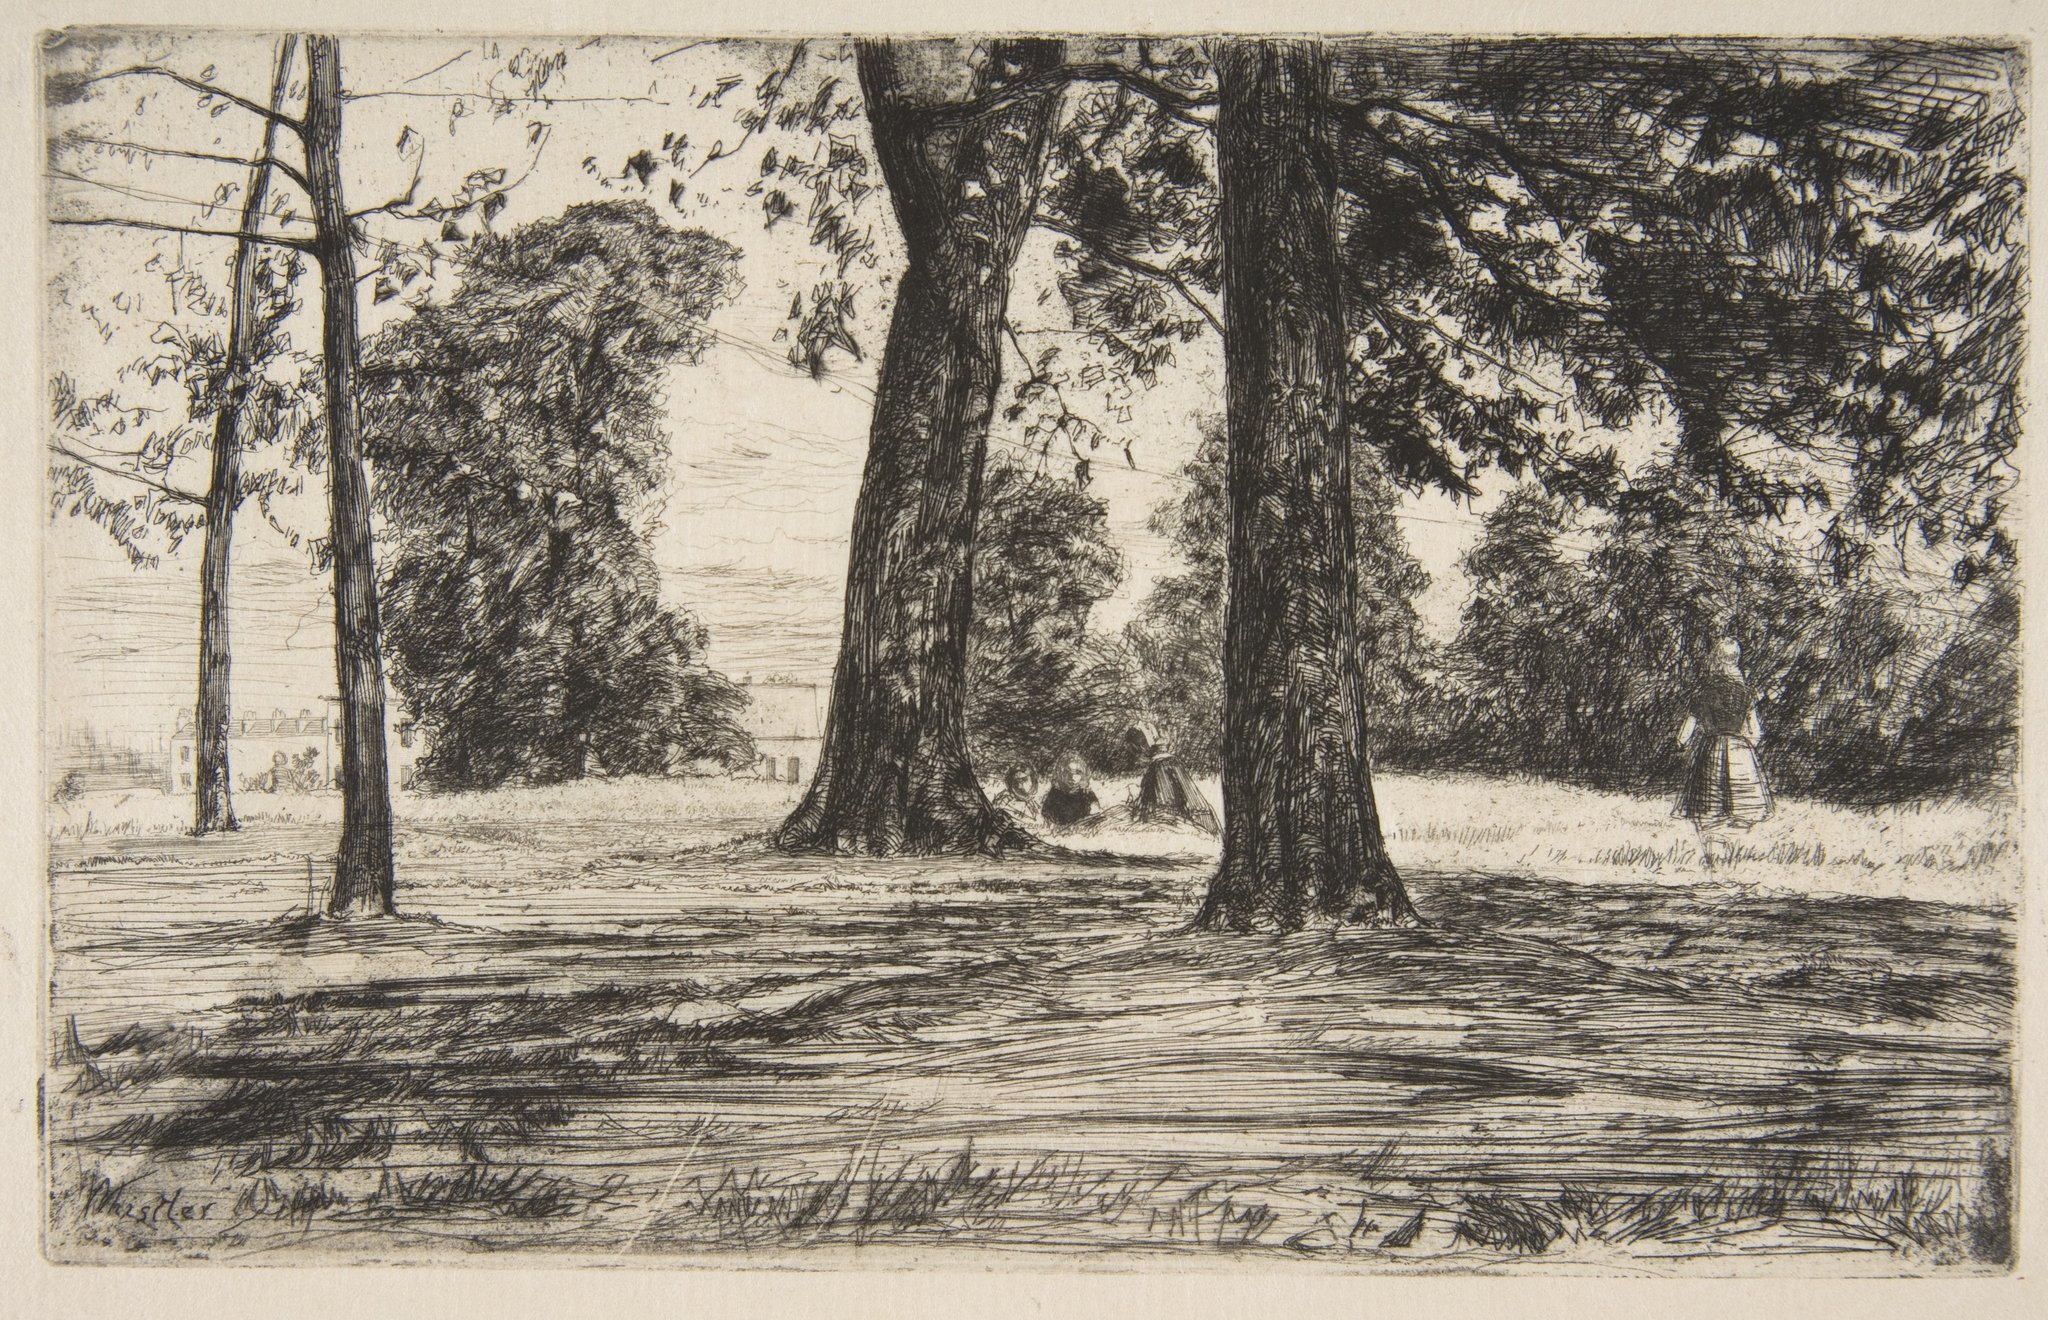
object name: print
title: Greenwich Park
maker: james mcneill whistler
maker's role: artist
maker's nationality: american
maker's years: 1834-1903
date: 1859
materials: ink, paper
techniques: drypoint, etching, printing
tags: parks,trees,london